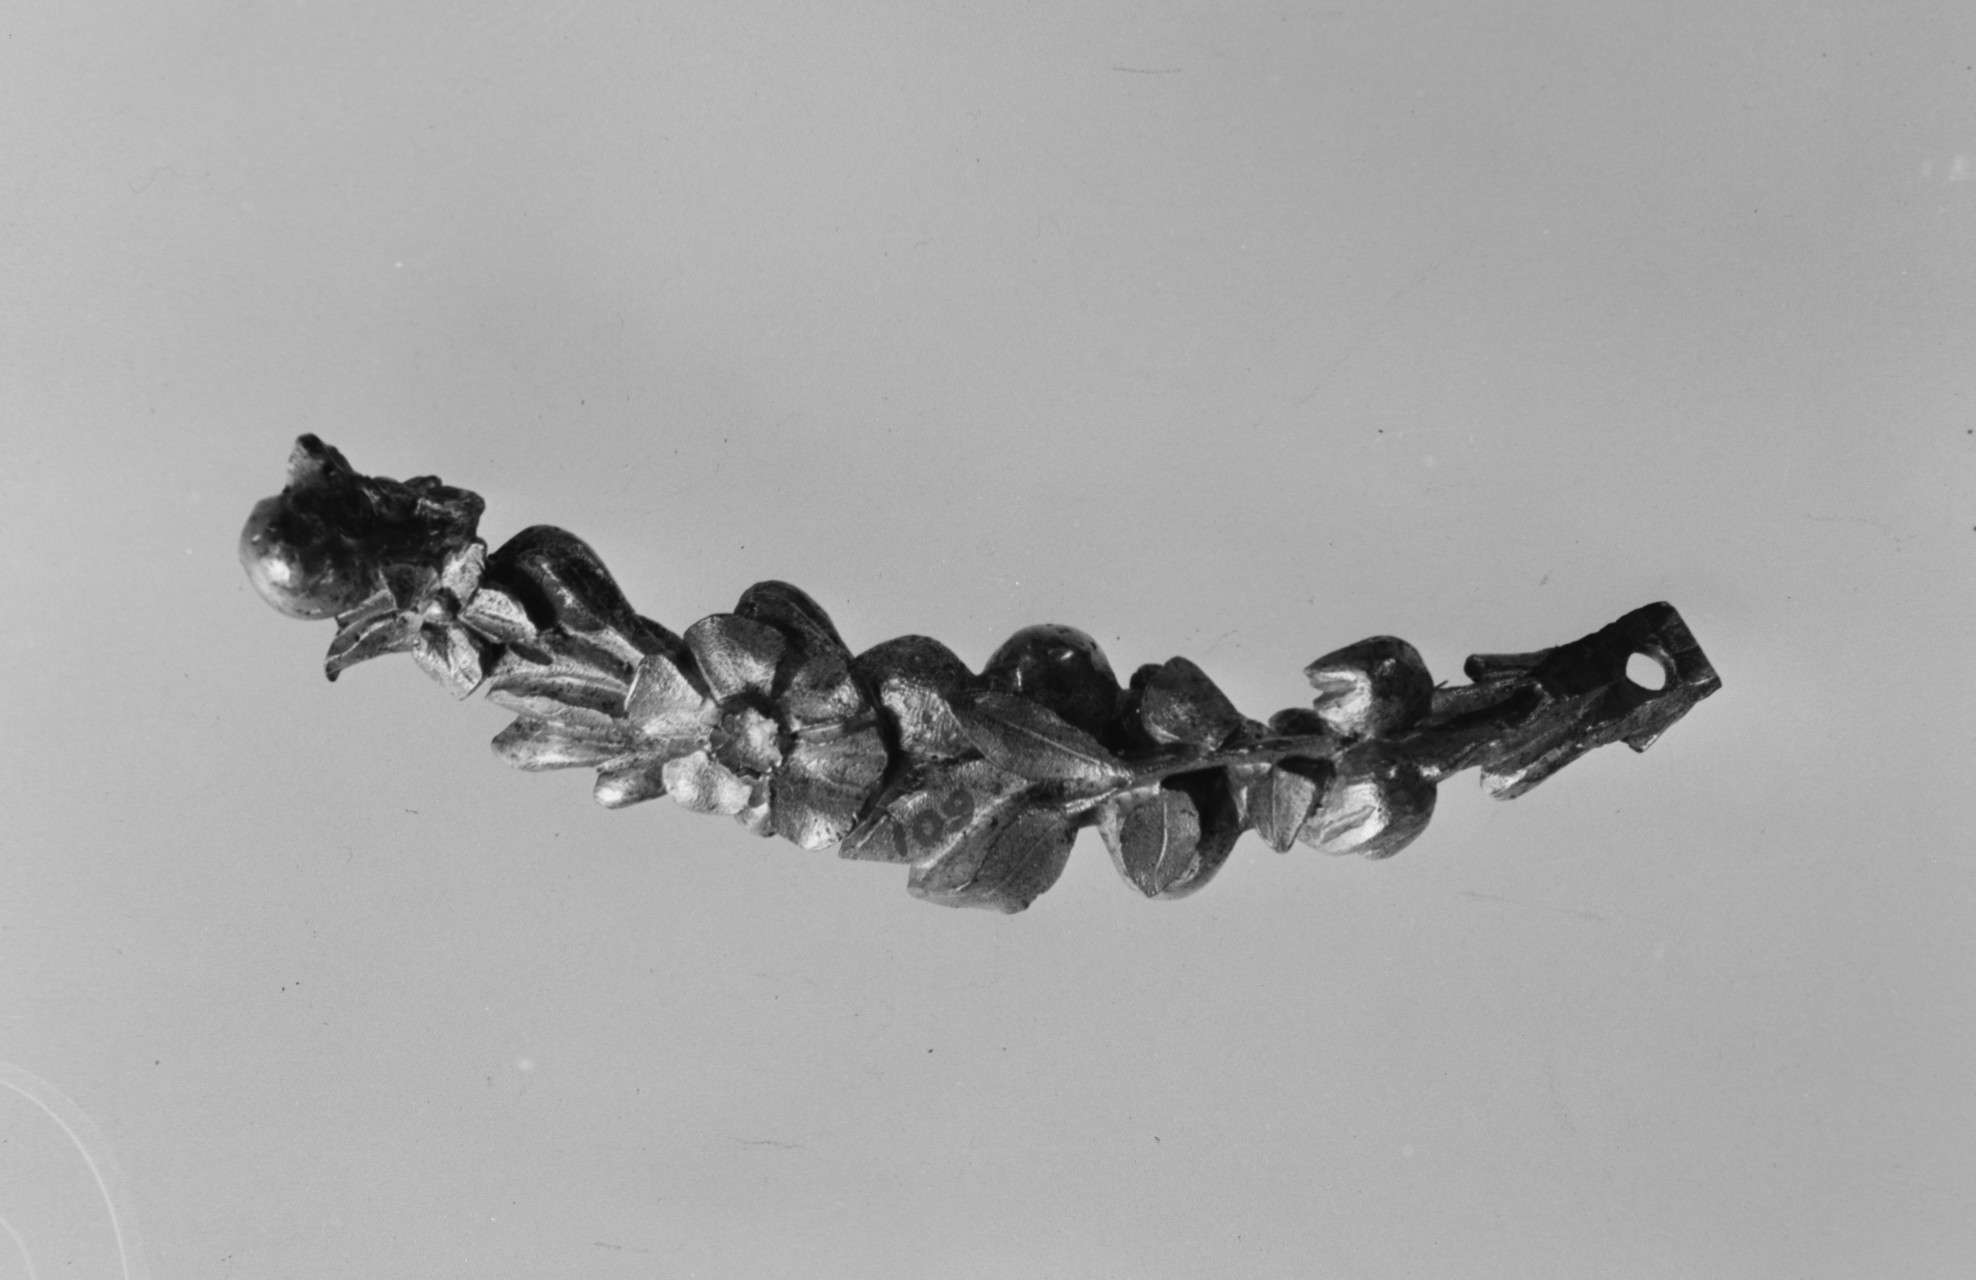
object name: clock ornament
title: Clock ornament (?)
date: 1701-1800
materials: gilt bronze